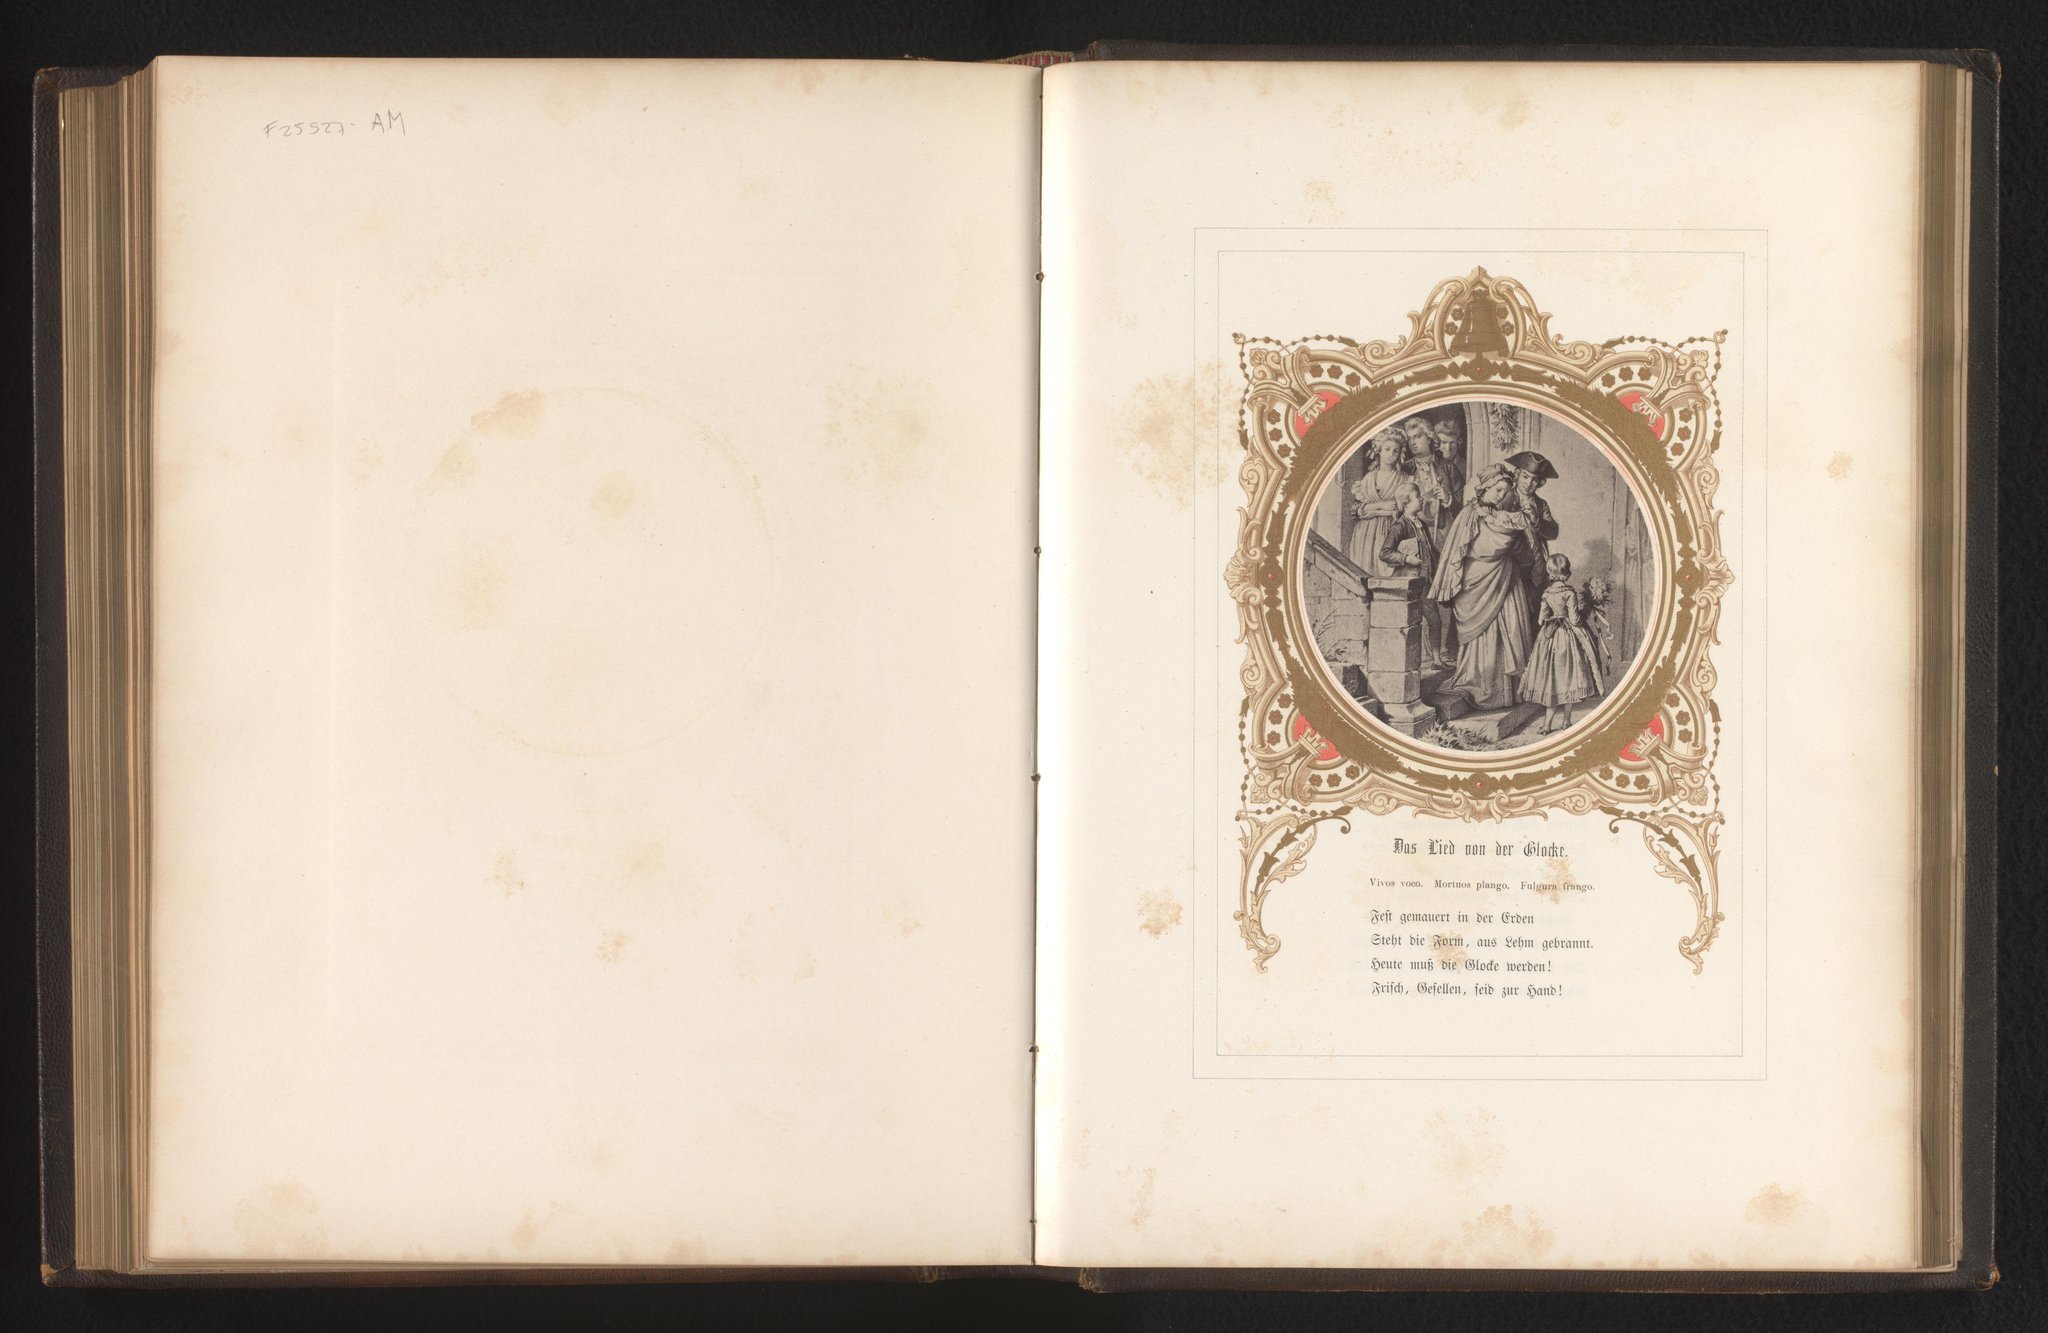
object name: page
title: Fotoreproductie van een tekening van personen op een trap door Arthur von Ramberg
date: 1855-1862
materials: paper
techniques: albumen print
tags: front steps